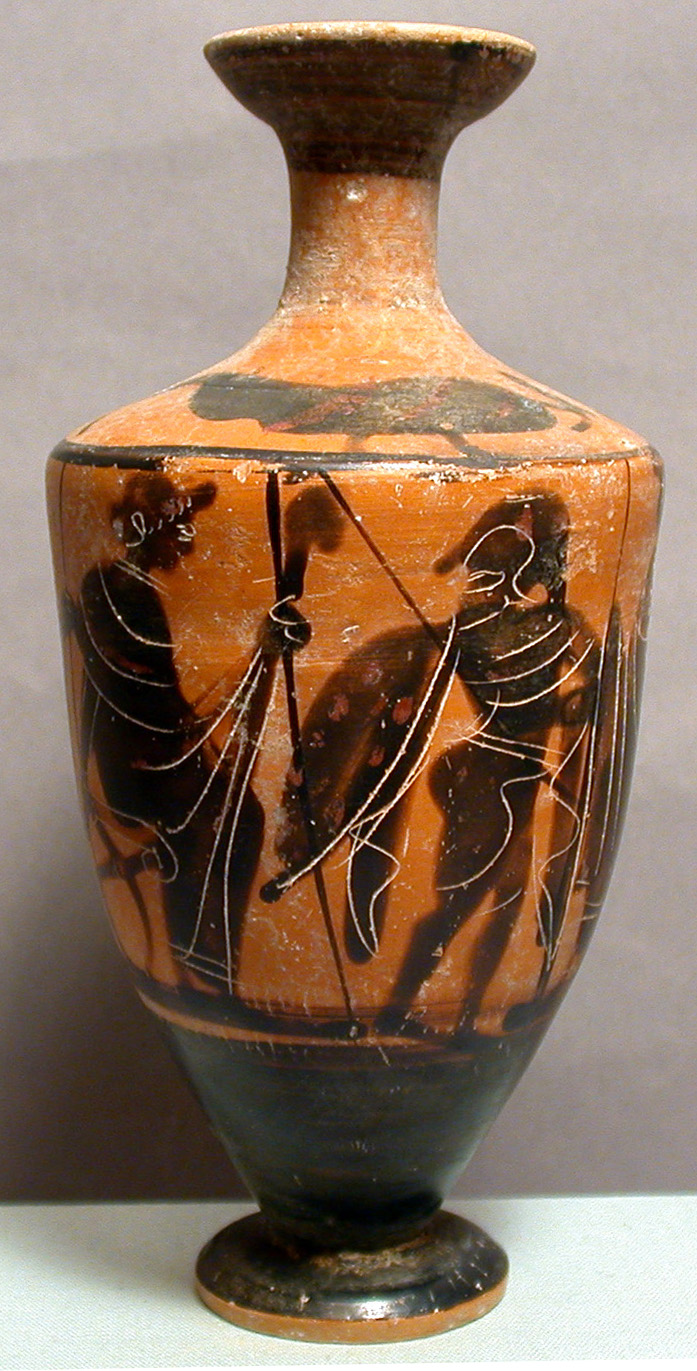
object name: lekythos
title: Terracotta lekythos (oil flask)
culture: greek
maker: attributed to the cock painter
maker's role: artist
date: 525-501 BCE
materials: terracotta